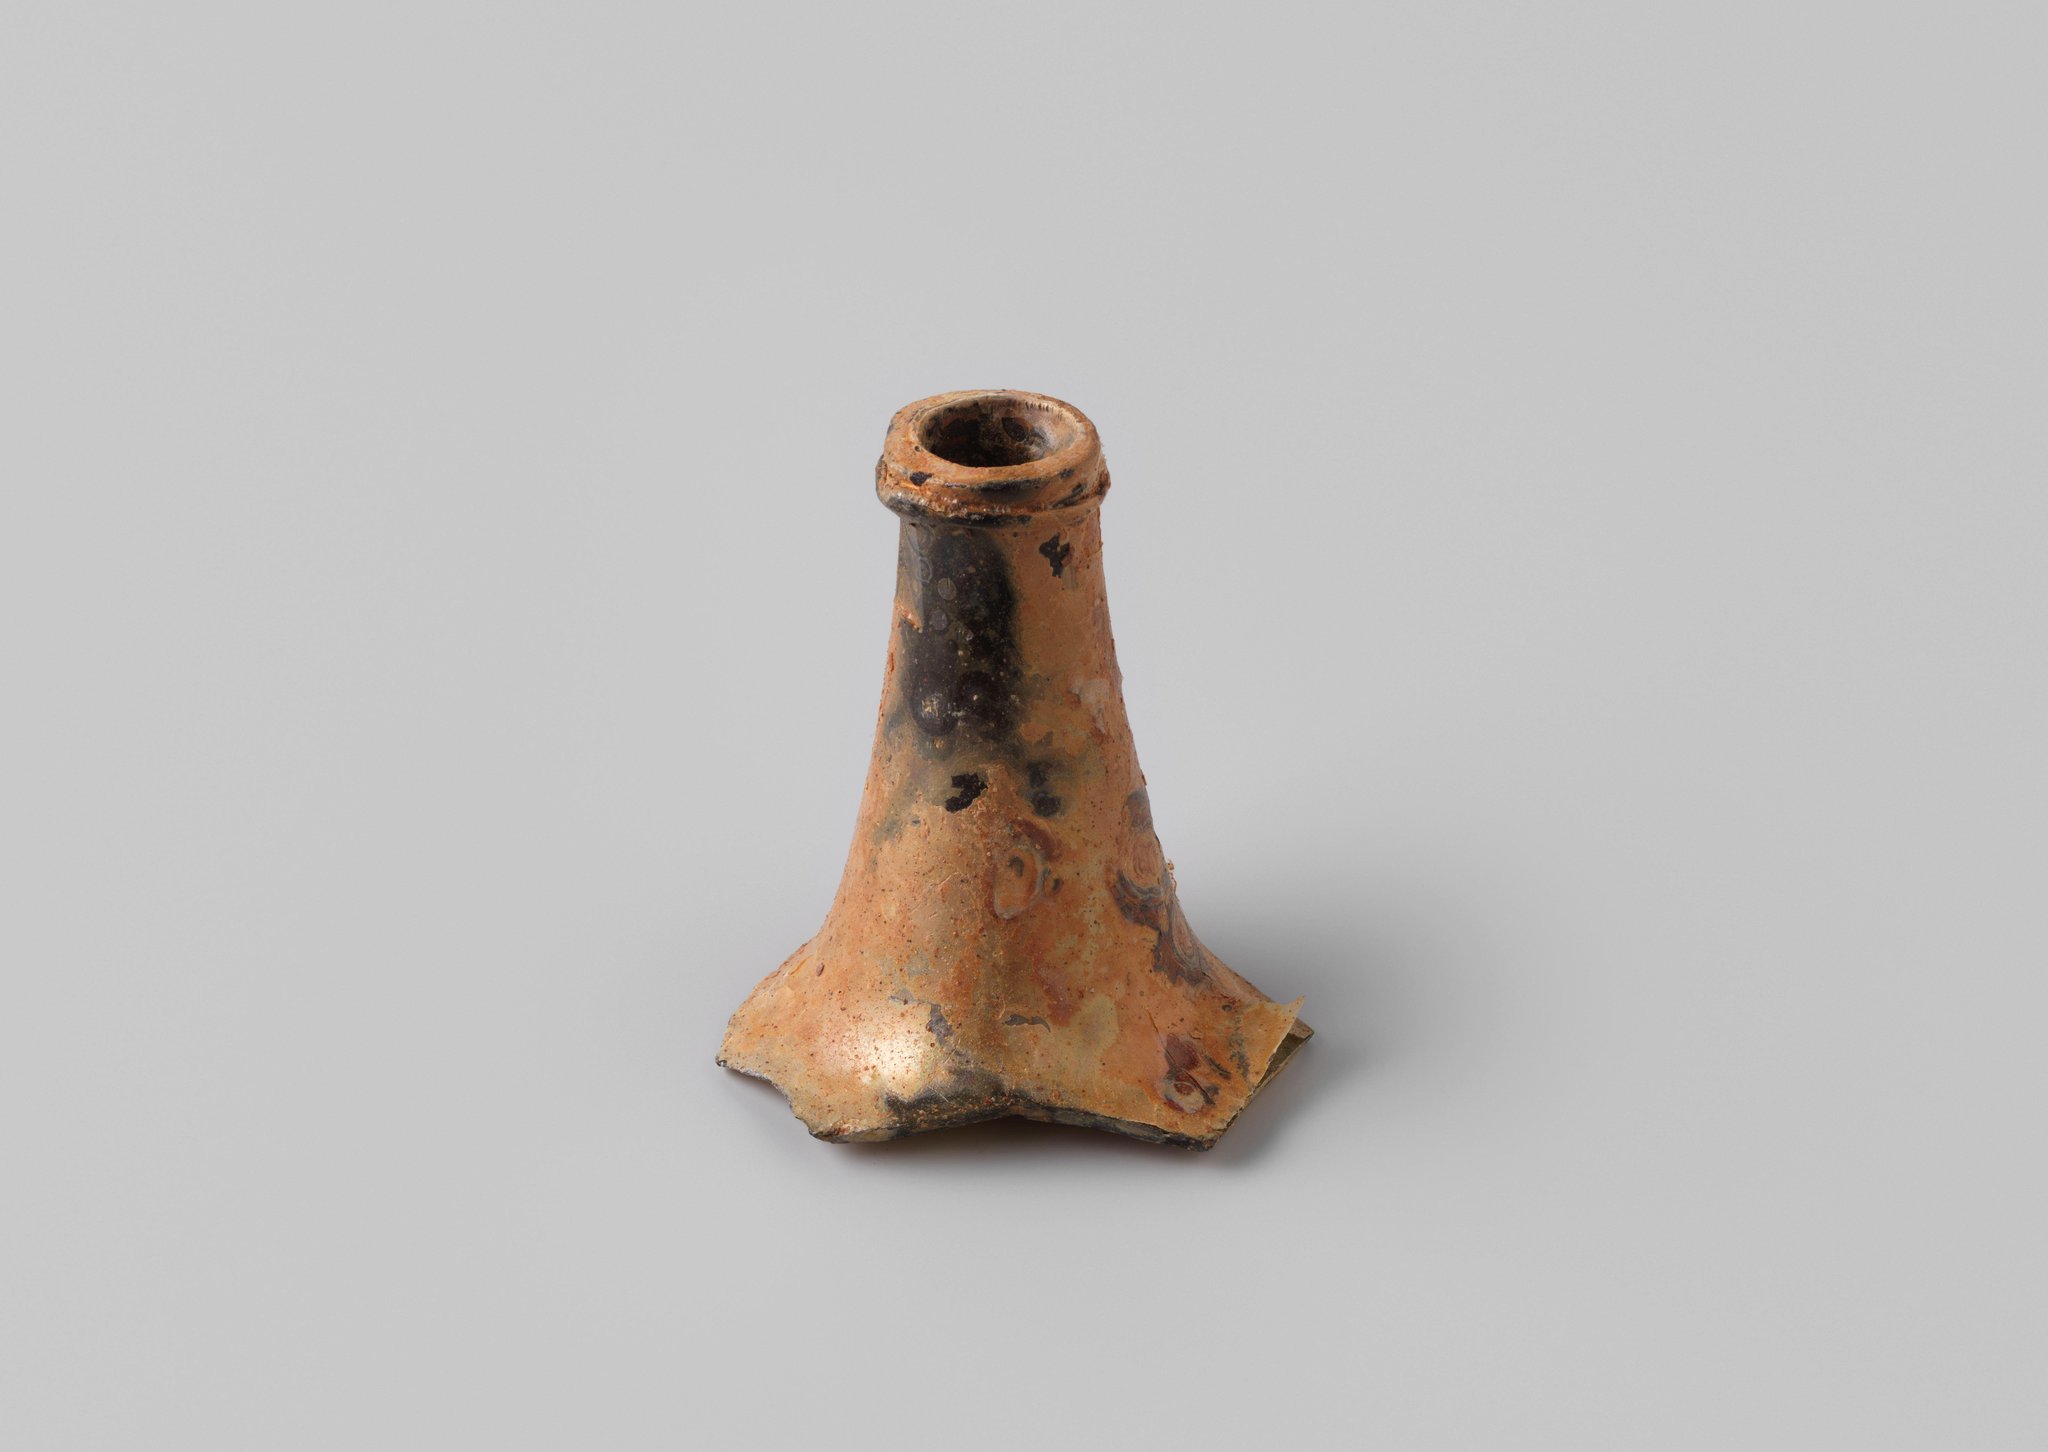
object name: sherd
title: Hals van een wijnfles uit het wrak van de Oost-Indiëvaarder Hollandia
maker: Anonymous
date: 1700-1743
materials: glass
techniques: green glass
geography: netherlands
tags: verenigde oostindische compagnie, hollandia (schip), annet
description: Wine bottle, continental production, neck, onion-shaped bottle or bottle with vertical side; eroded, thin r-string rim